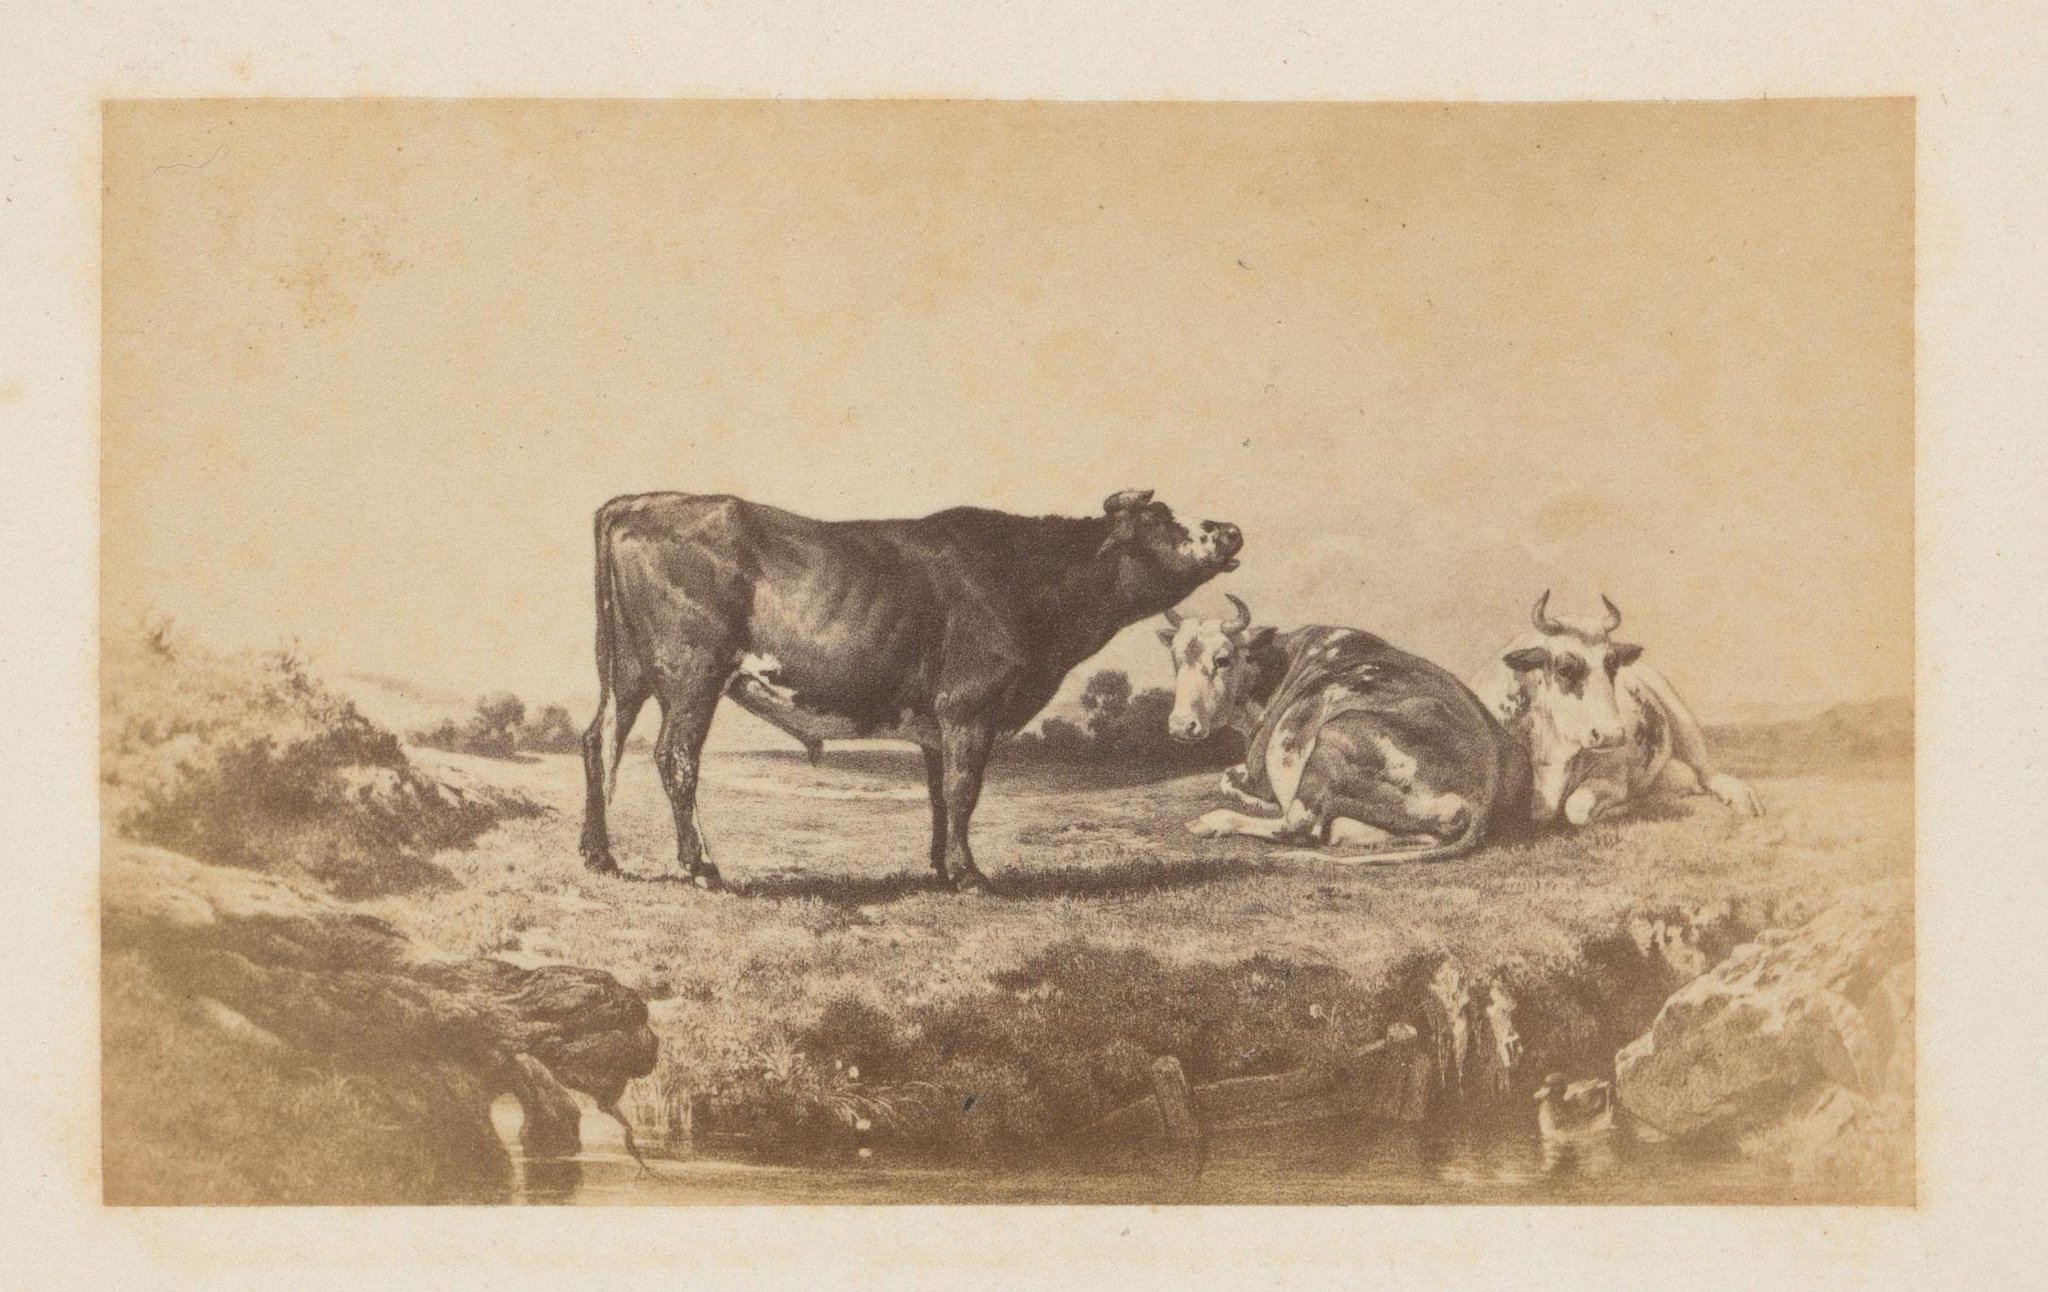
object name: photograph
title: Fotoreproductie van een schilderij van Rosa Bonheur van runderen in een landschap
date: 1890-1910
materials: paper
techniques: albumen print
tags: bull, cow